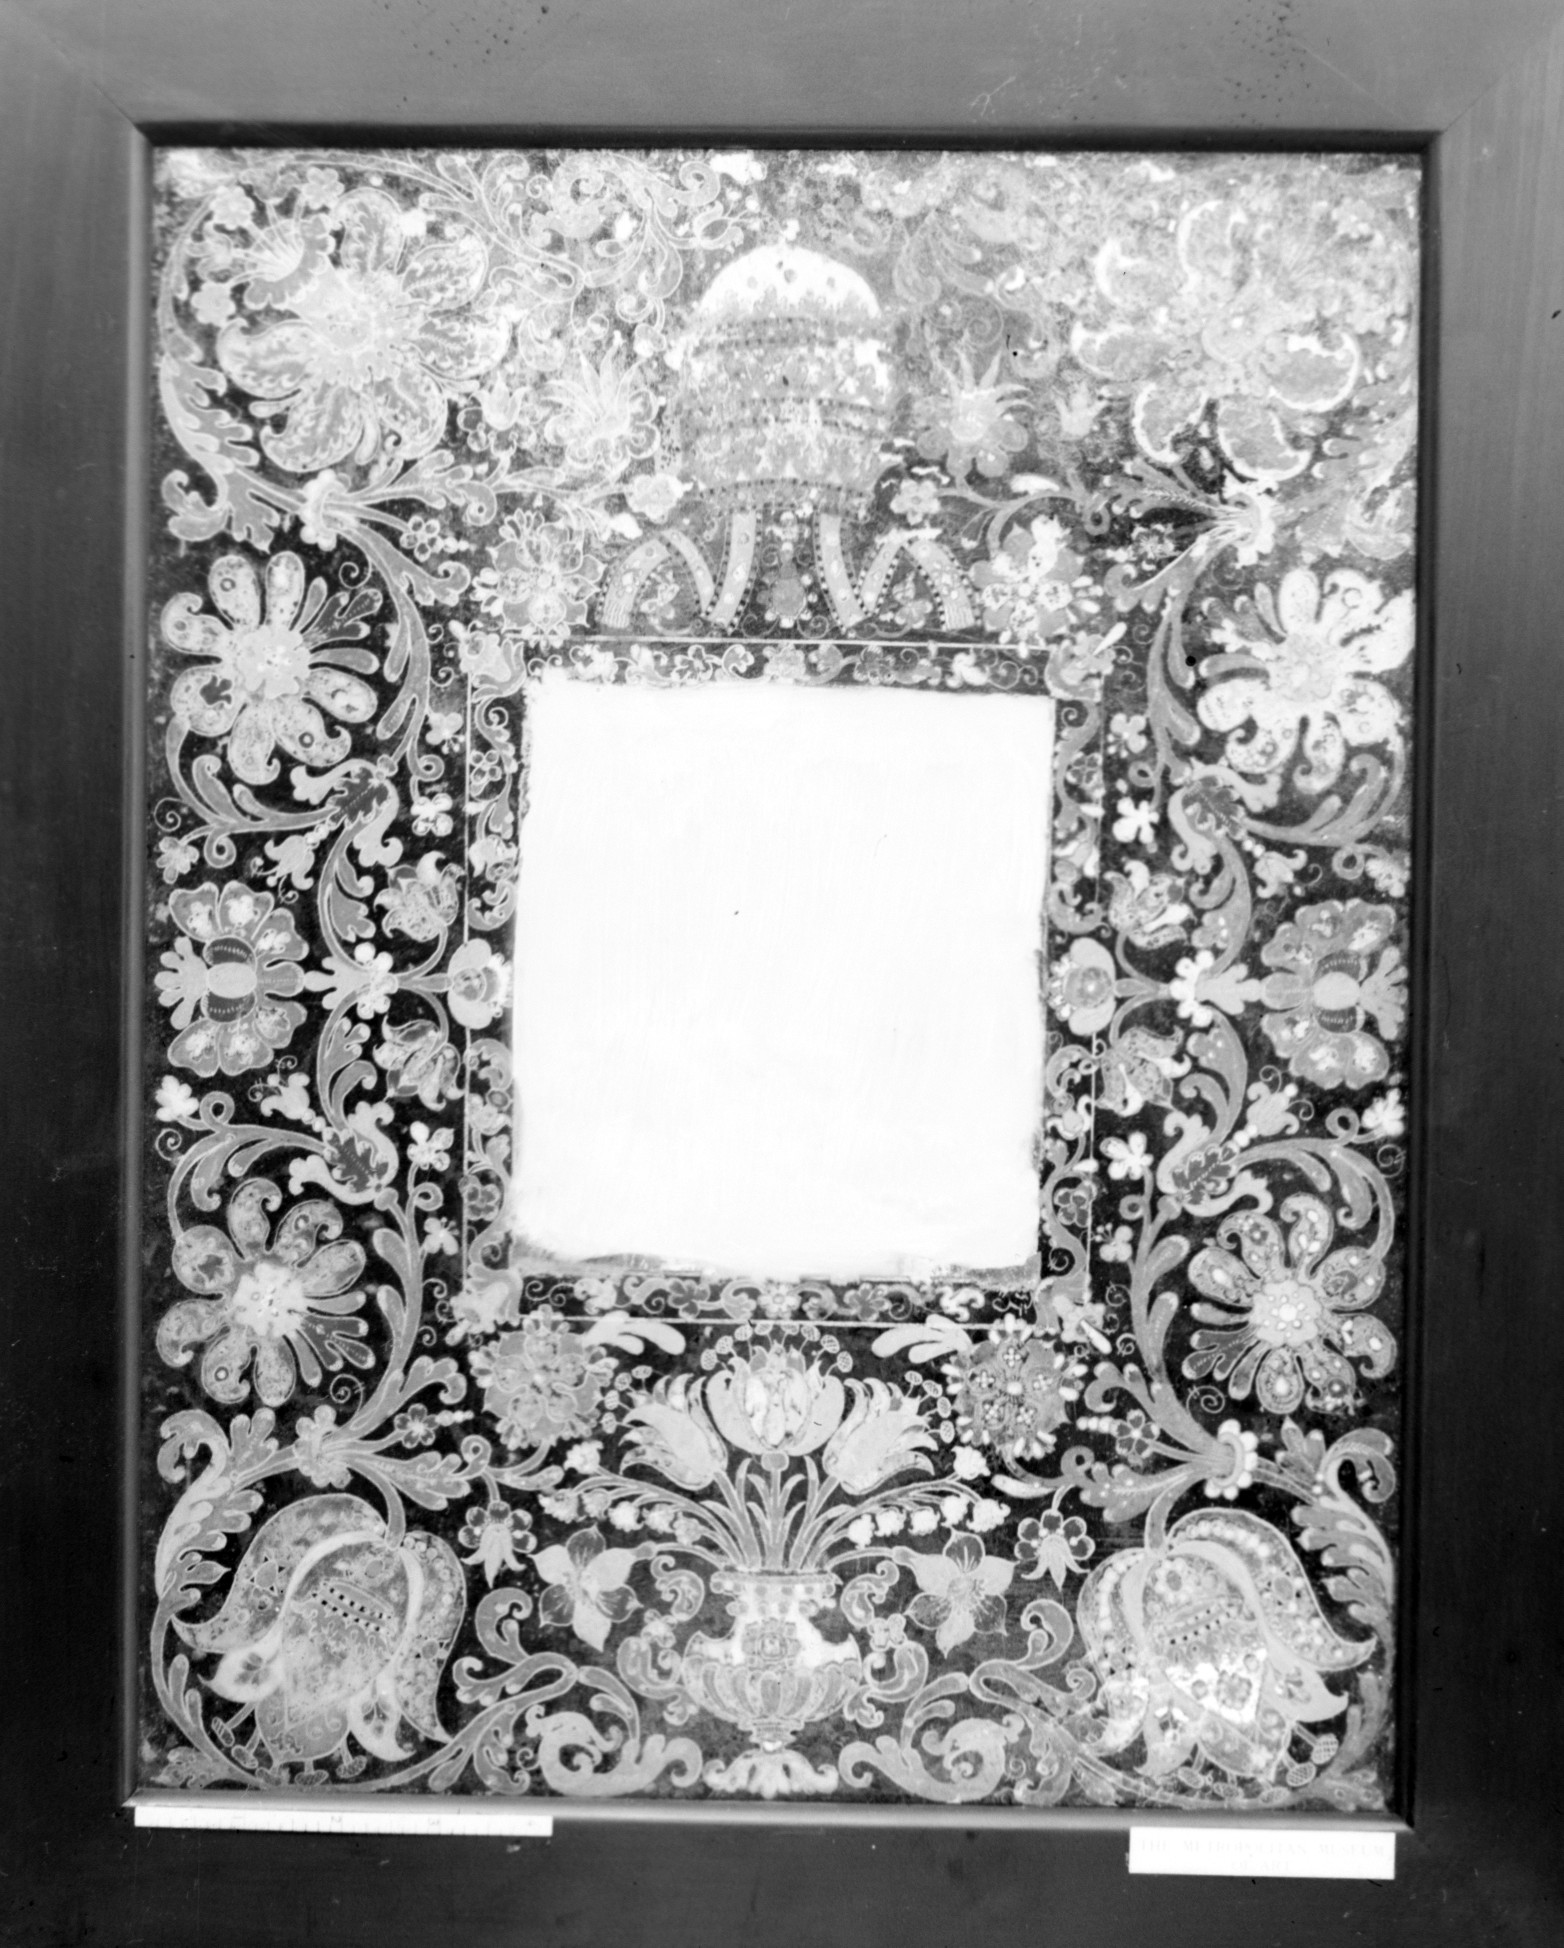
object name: frame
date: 1601-1700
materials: glass